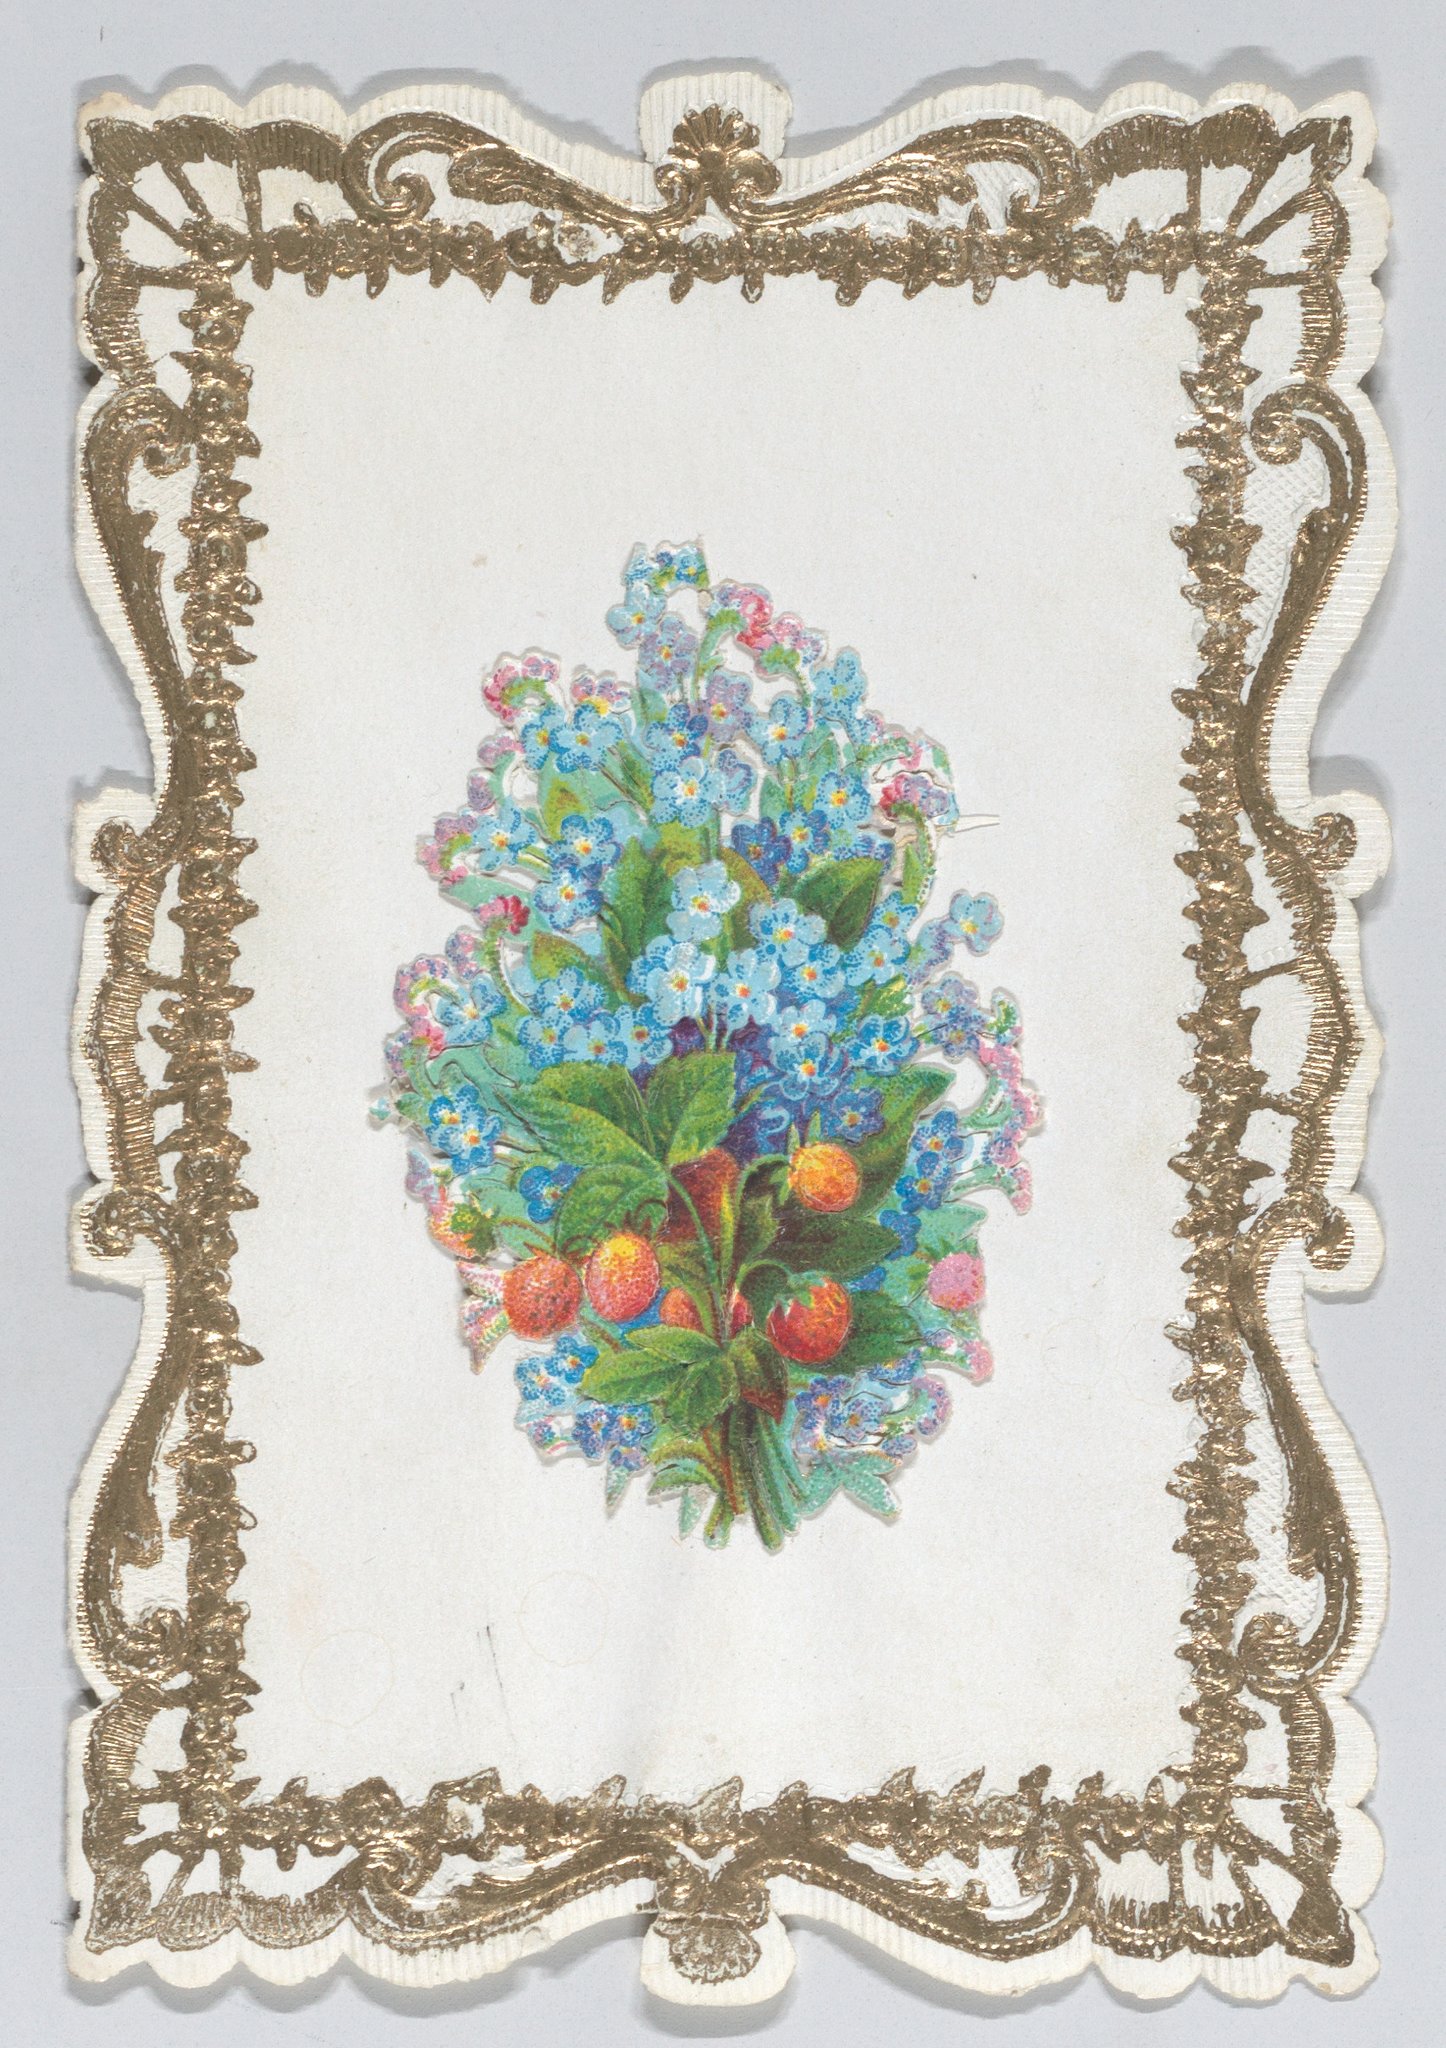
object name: valentine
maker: Anonymous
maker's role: artist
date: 1847-1870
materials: paper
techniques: chromolithography, embossing, gilding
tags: flowers